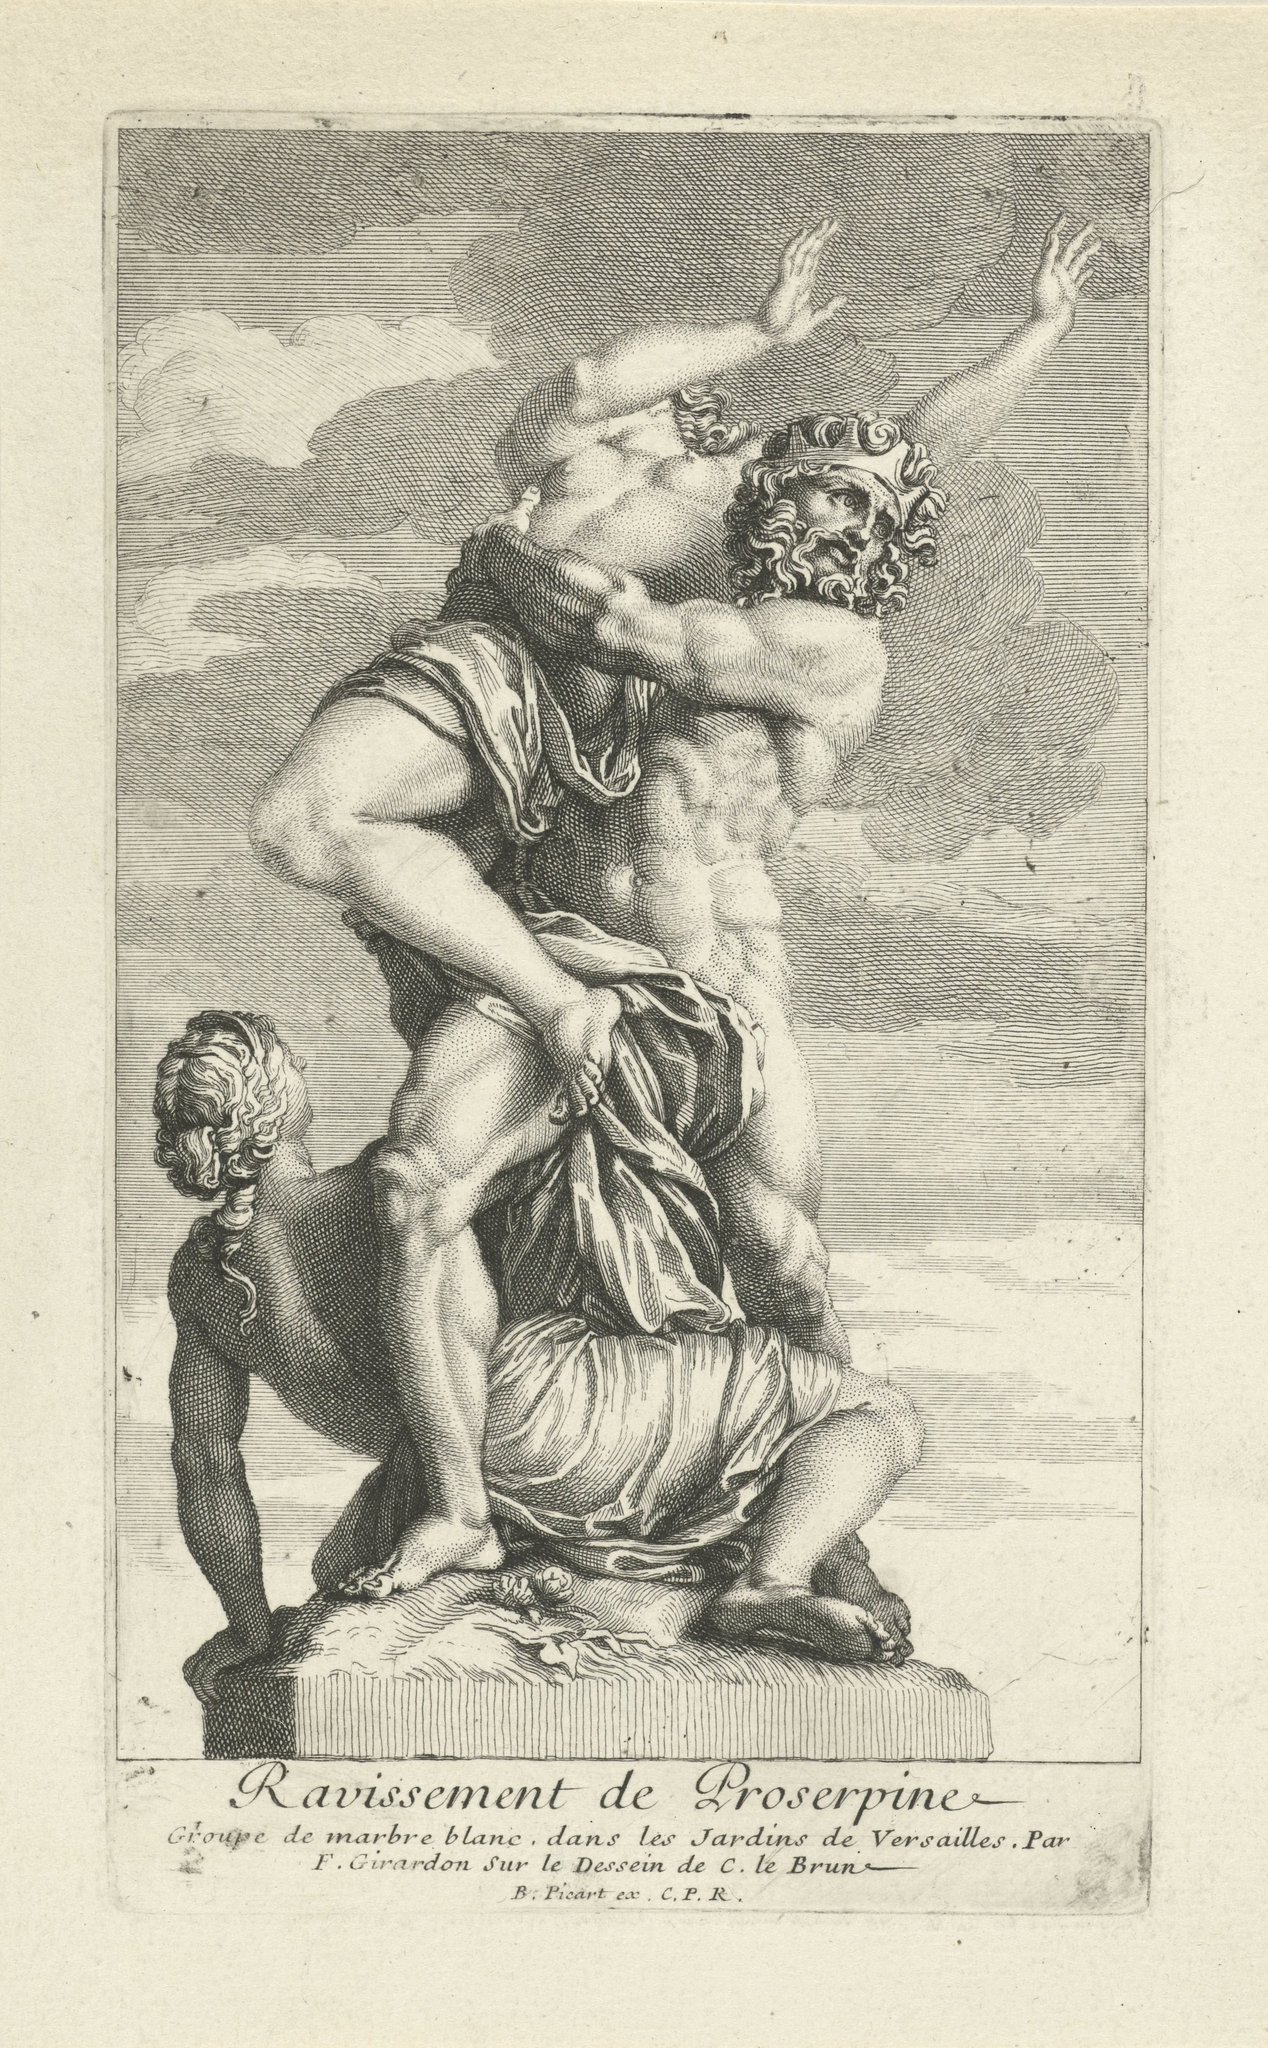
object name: print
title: Standbeeld met de roof van Proserpina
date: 1699-1733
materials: paper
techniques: engraving, etching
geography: paris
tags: the rape of proserpina (by pluto in his chariot); possibly with diana and minerva trying to rescue her, piece of sculpture, reproduction of a piece of sculpture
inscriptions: inscription: ‘3 st’, collector's mark: Lugt 2228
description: Beeldengroep in de tuinen van Versailles. Pluto grijpt Proserpina om haar mee te nemen op zijn wagen. Een nimf probeert hem tegen te houden maar is gevallen. In de marge een onderschrift in het Frans.